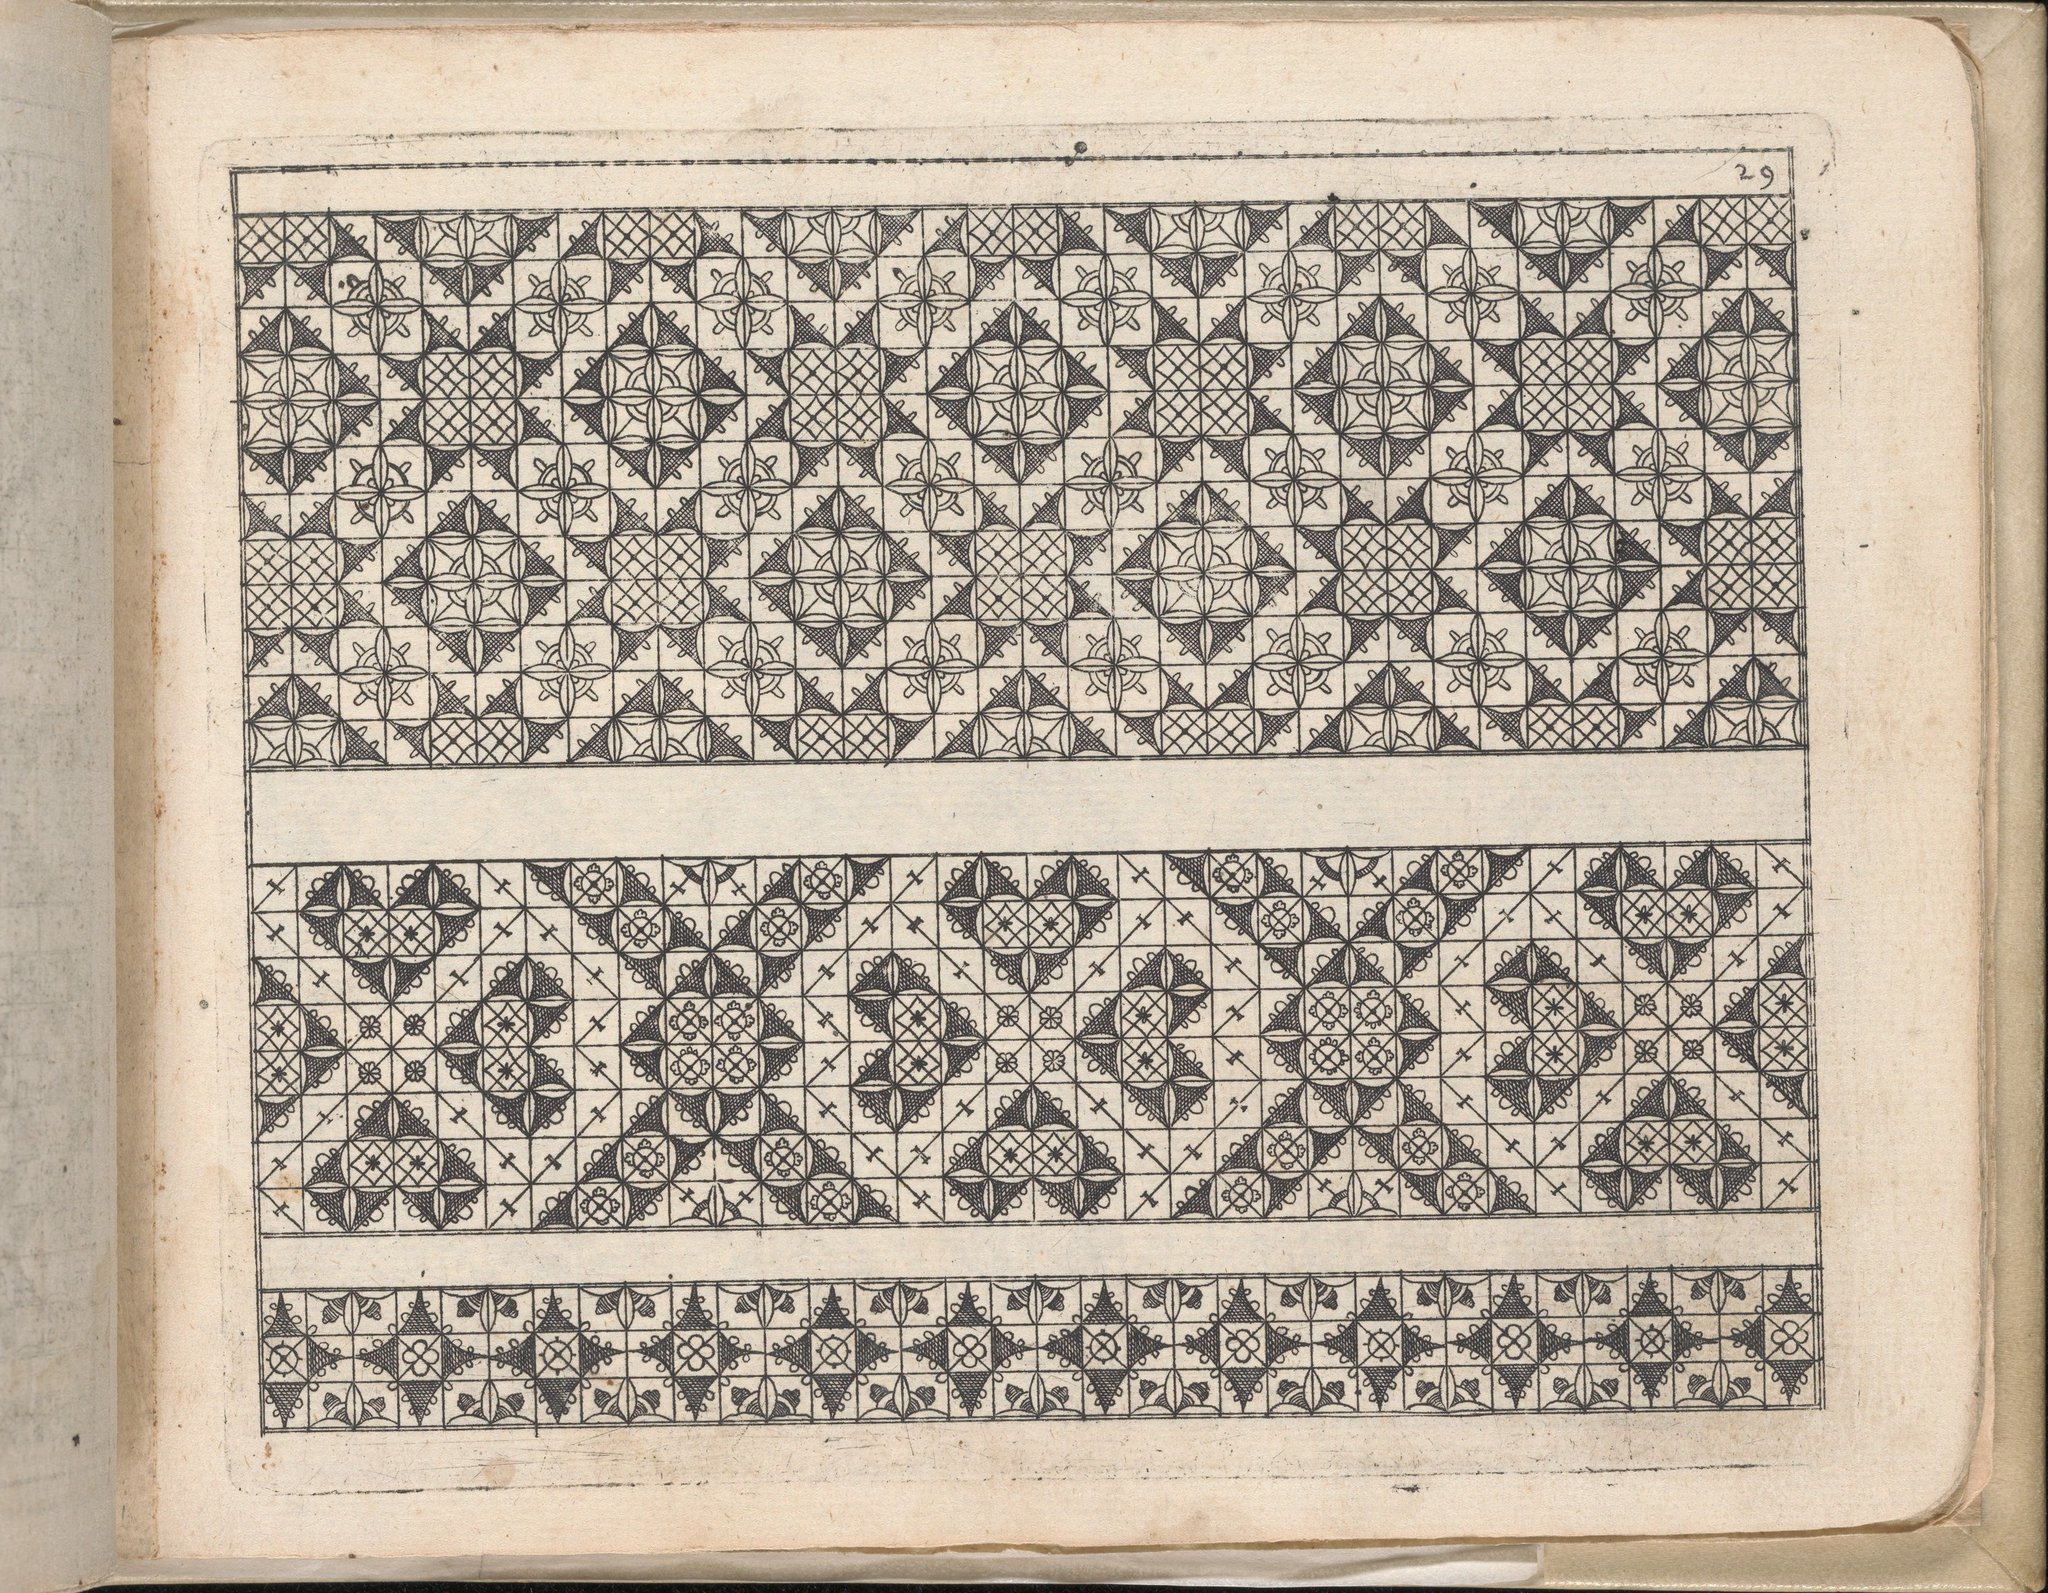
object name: book print ornament architecture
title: Schön Neues Modelbuch (Page 34 recto)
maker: johann sibmacher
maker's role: designer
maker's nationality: german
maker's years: 1590-1611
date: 1597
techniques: etching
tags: ornament